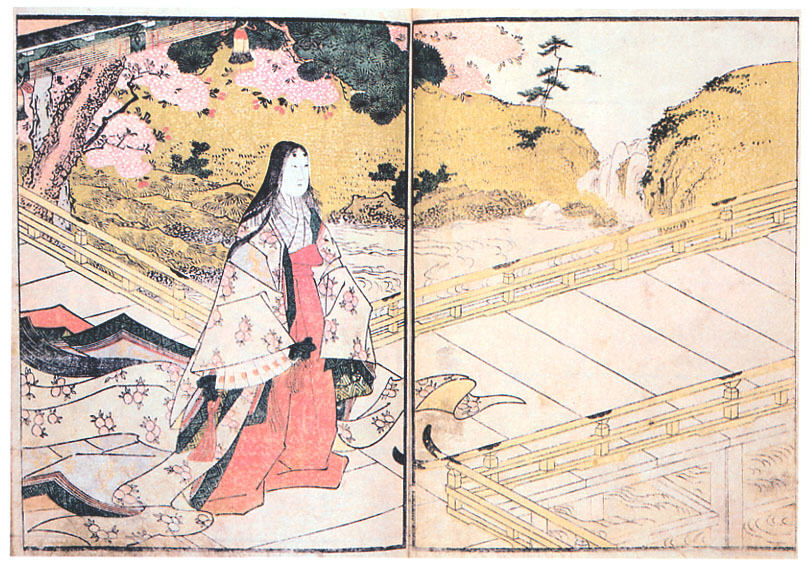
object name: illustrated book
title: Illustrated Book of the Current Fashion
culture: japanese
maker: utagawa toyokuni i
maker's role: artist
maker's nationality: japanese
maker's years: 1769-1825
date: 1802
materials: ink, paper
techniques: polychrome, woodblock print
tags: women